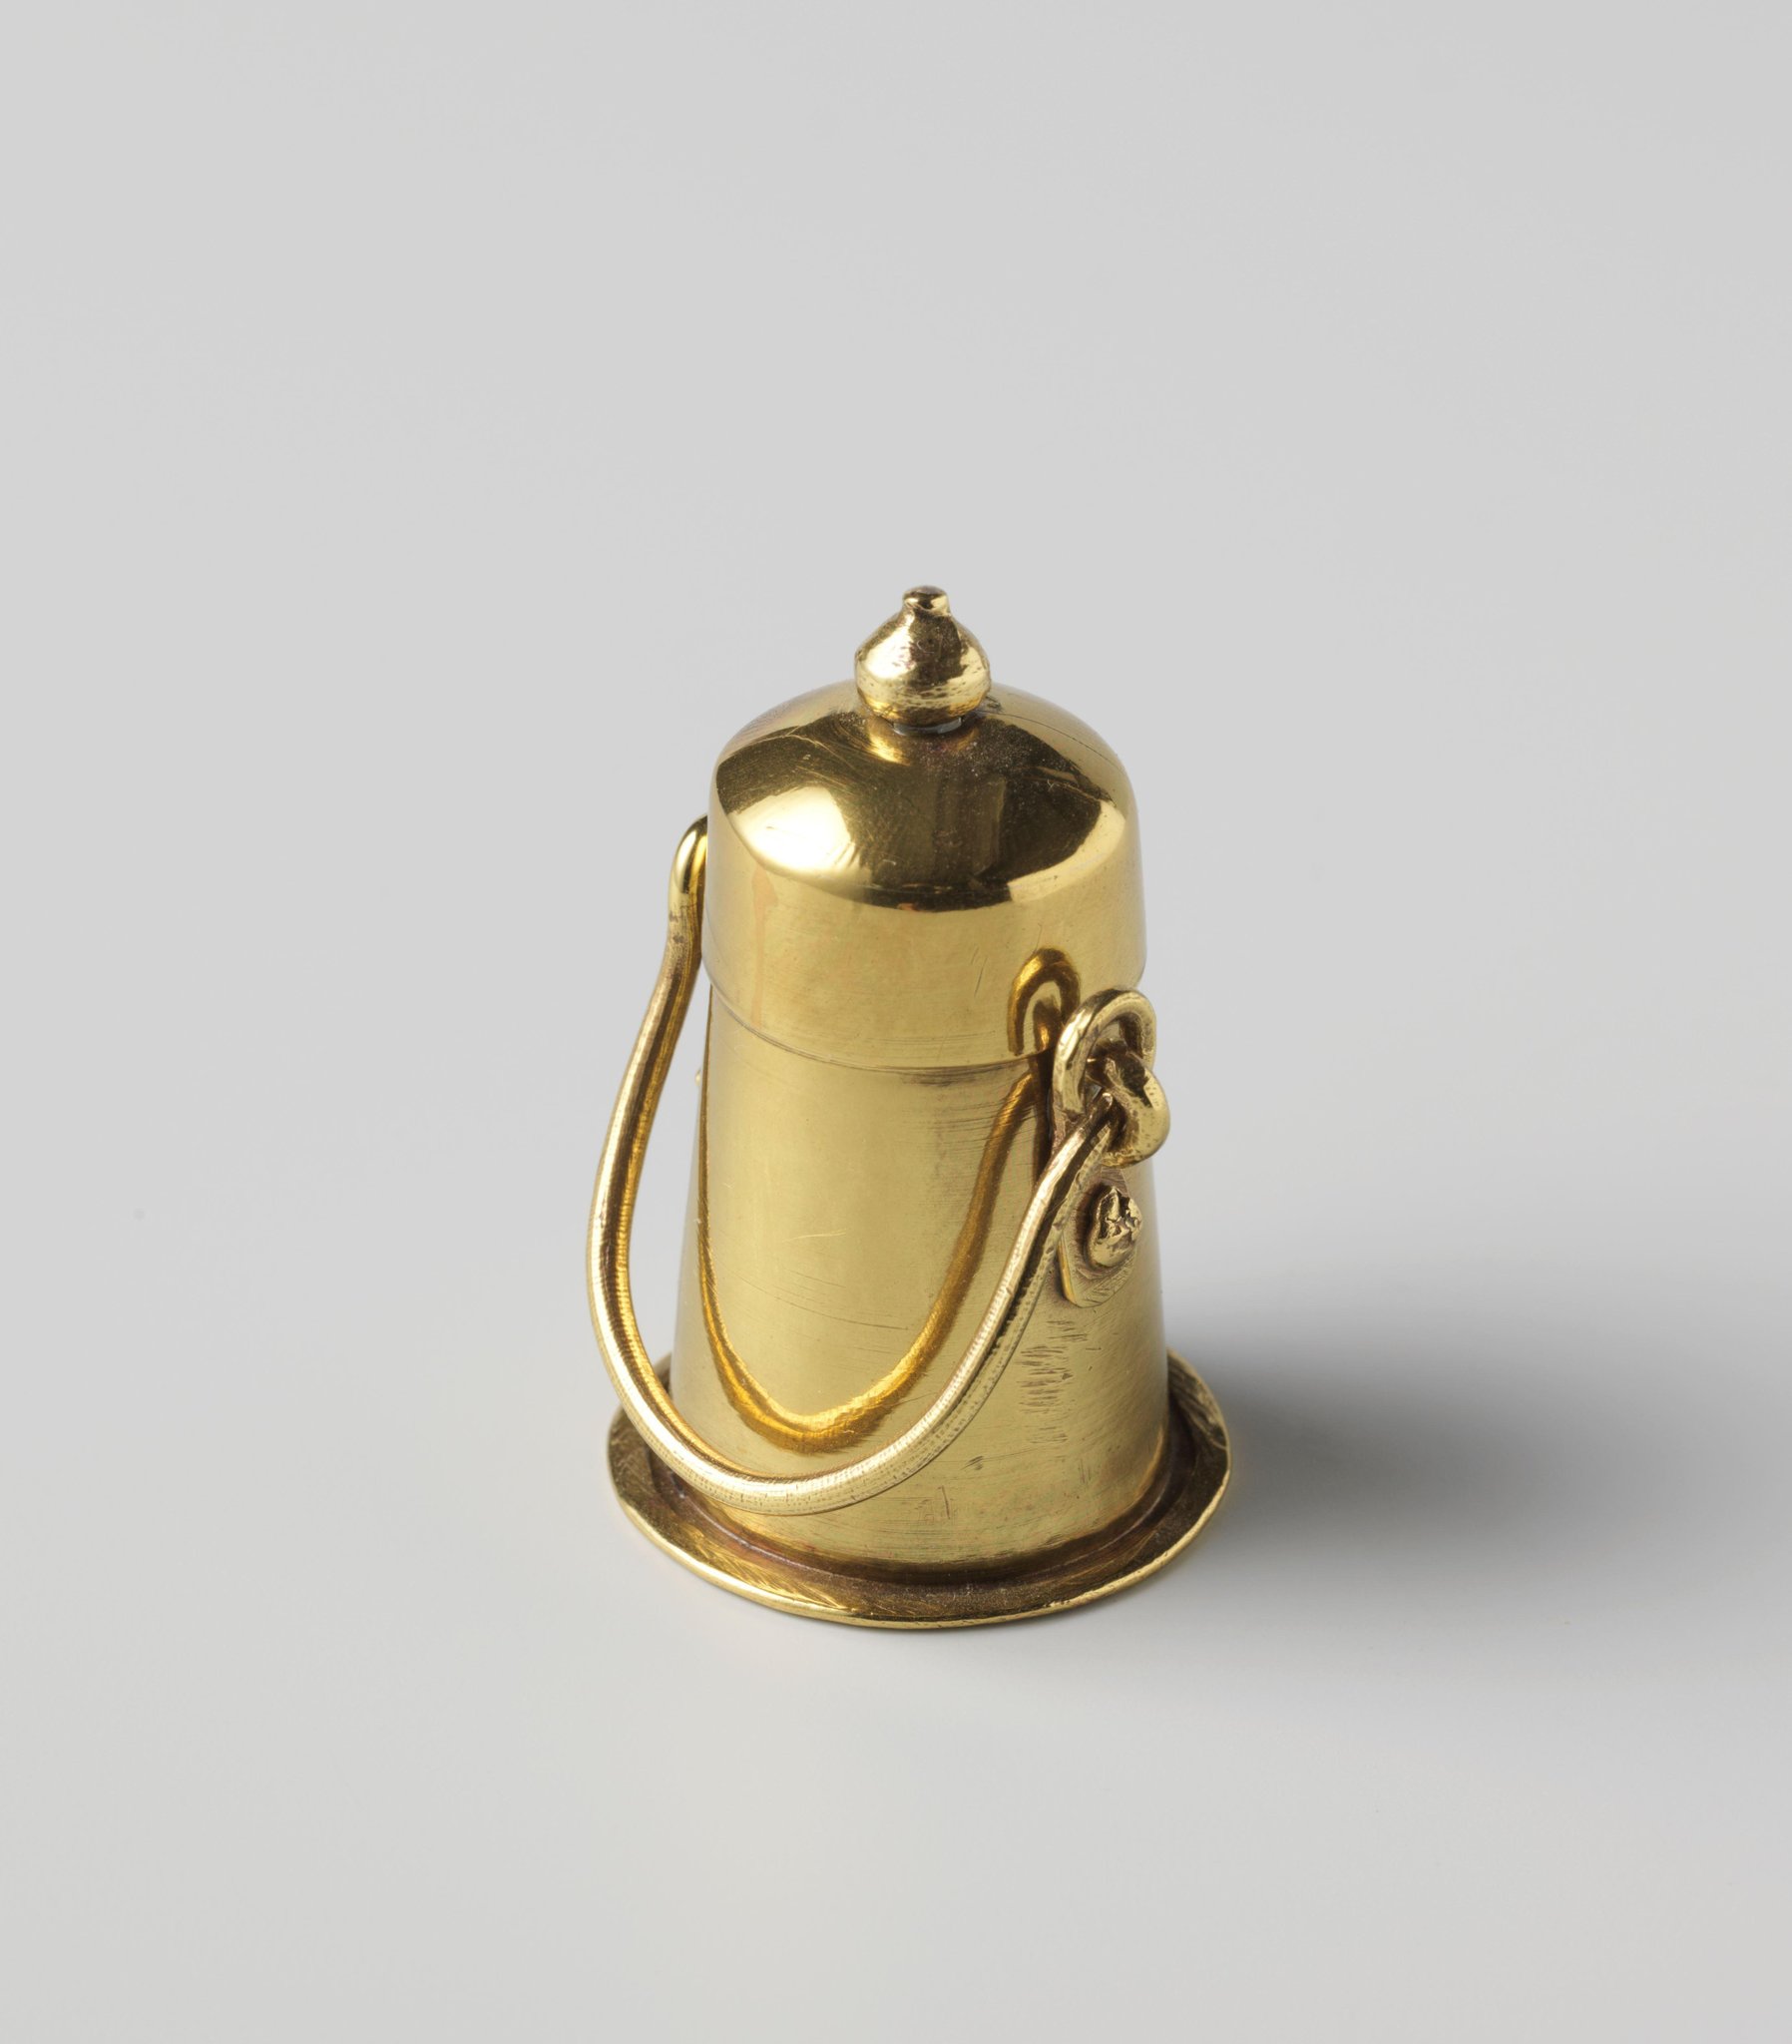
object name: doofpot, vuurdover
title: Doofpot met deksel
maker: Anonymous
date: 1700-1799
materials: brass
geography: amsterdam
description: Doofpot van geelkoper, met losse deksel.